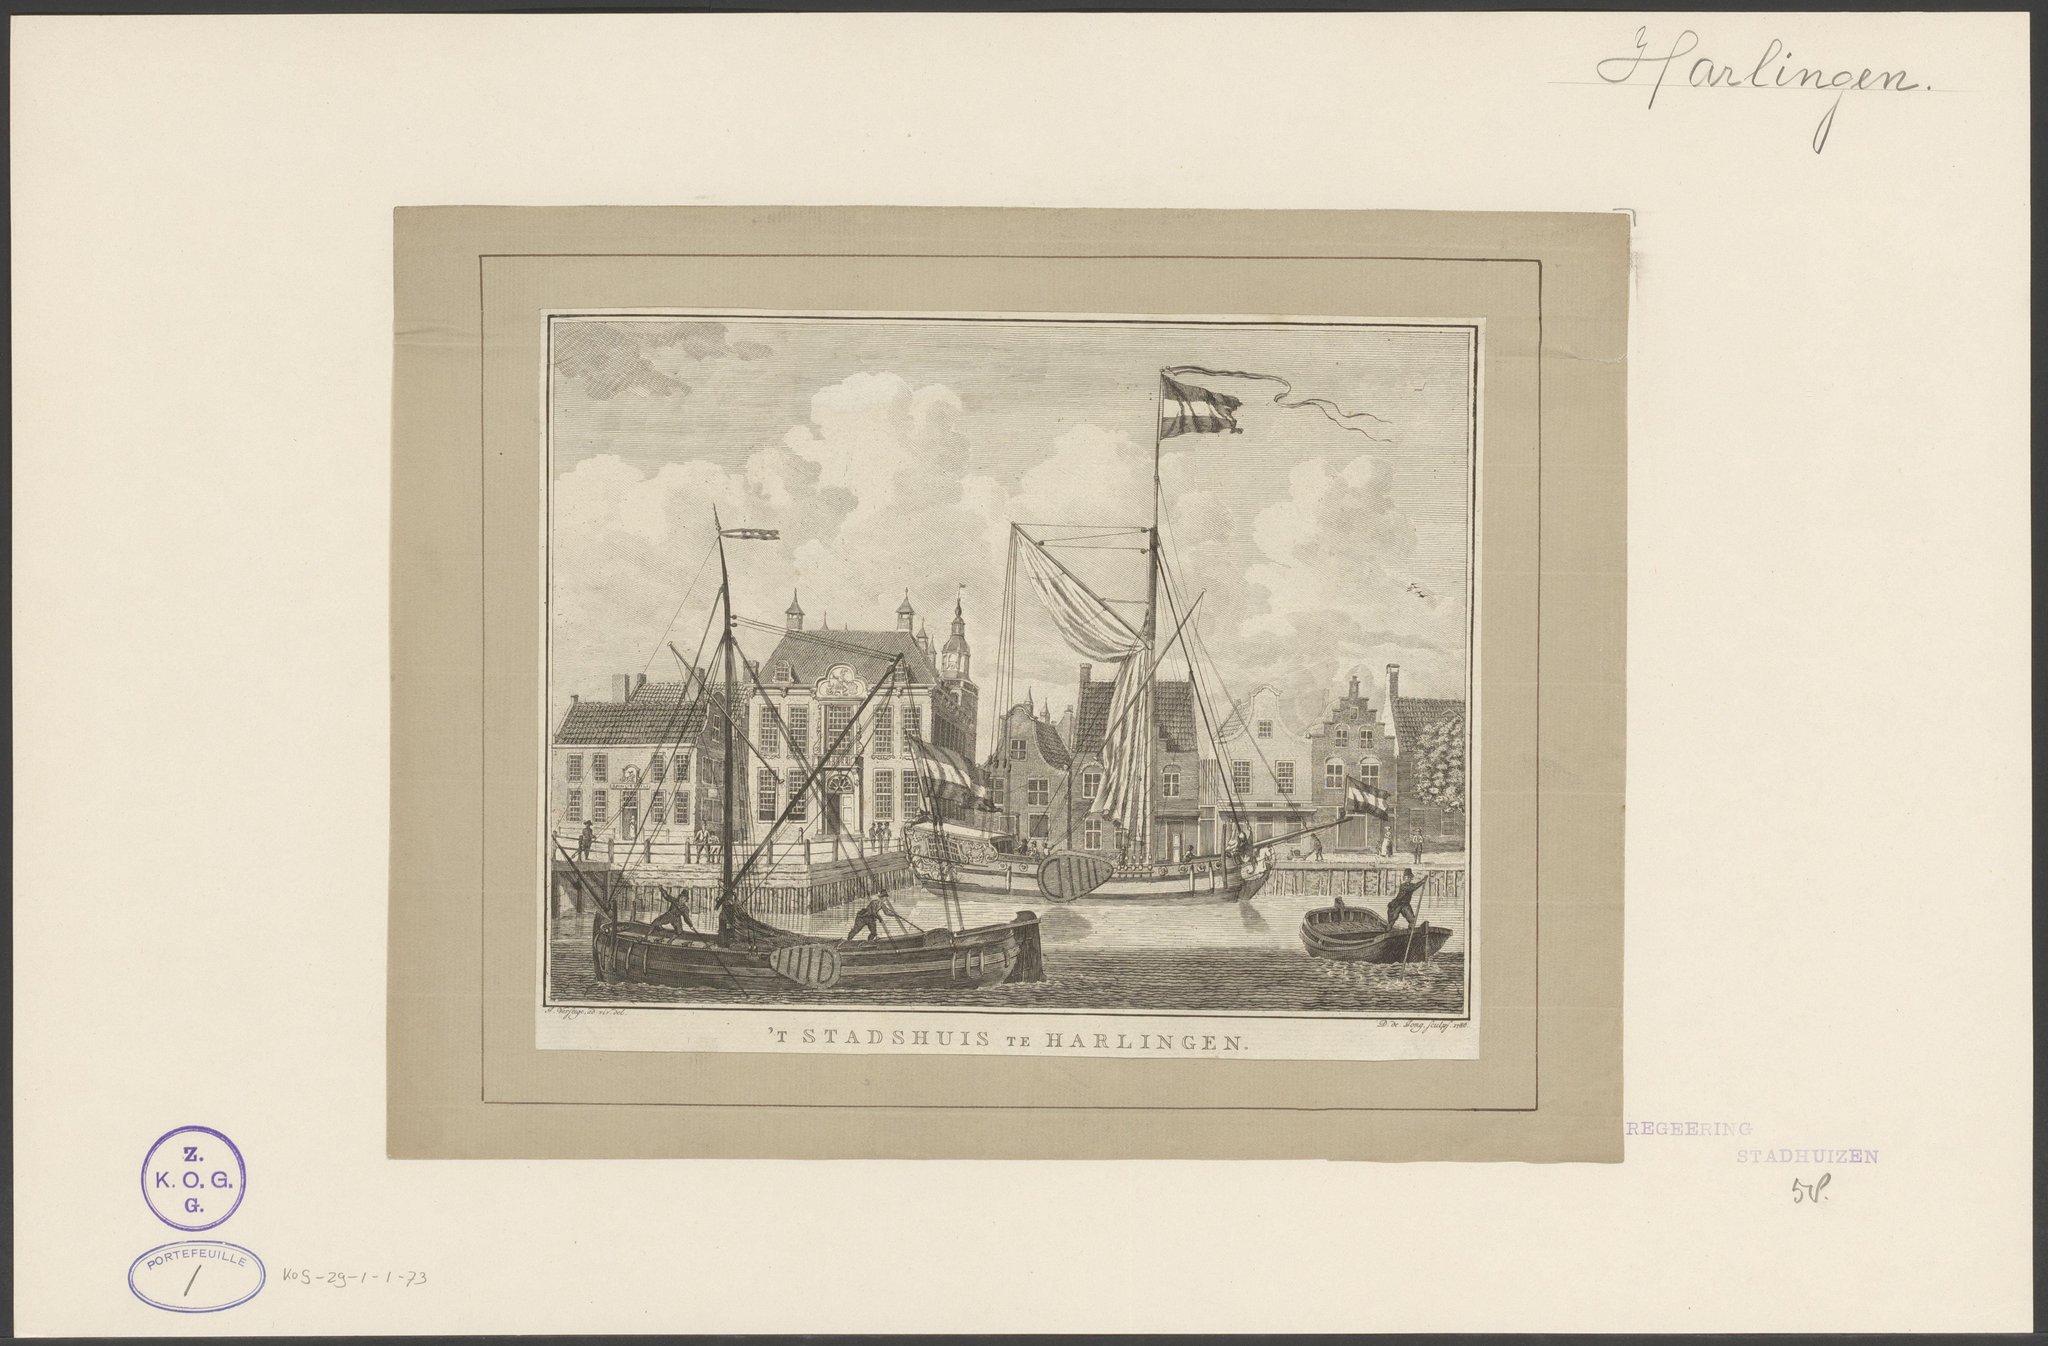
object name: print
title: 't Stadhuis te Harlingen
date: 1786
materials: paper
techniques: etching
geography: northern netherlands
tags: sailing-ship, sailing-boat, townhall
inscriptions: collector's mark, collector's mark: Lugt 1641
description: Gezicht op het stadhuis te Harlingen. Op de voorgrond het Friese statenjacht, een tjalk en een praam. Onderwerpsrubrieken binnen de Atlas Zeden en Gewoonten: Regeering, Stadhuizen (H-M).